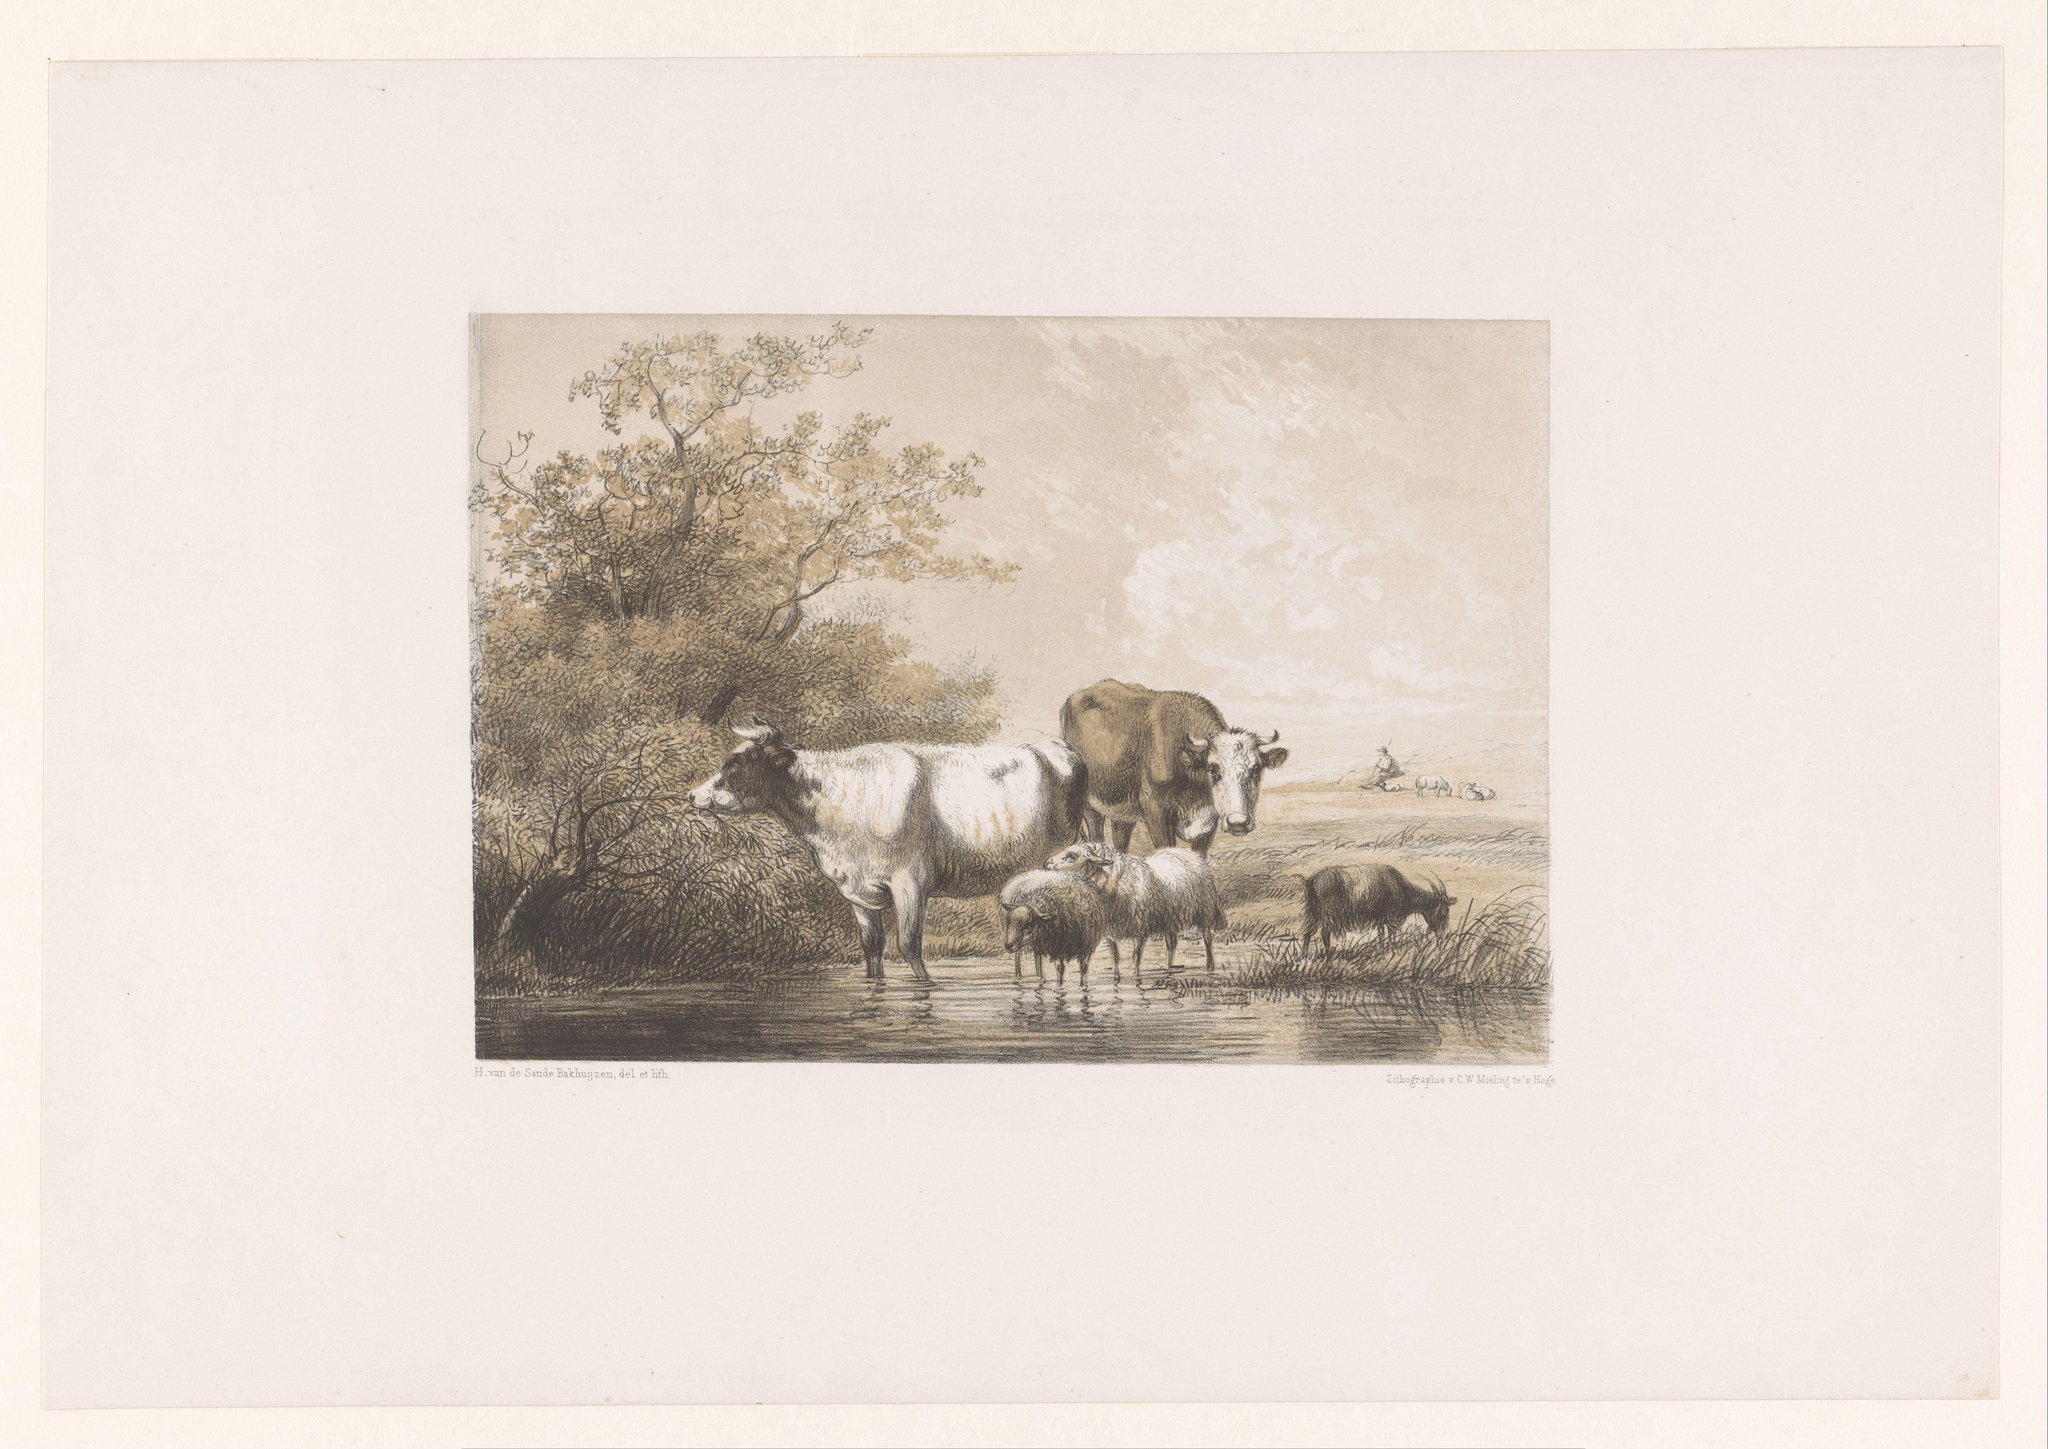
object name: print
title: Koeien en schapen in plas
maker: hendrikus van de sande bakhuyzen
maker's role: draughtsman, painter, print maker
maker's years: 1795-1860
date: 1847-1860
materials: paper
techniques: tone lithography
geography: the hague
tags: cow, sheep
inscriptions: collector's mark: Lugt 2228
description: Twee koeien, twee schapen en een geit staan in een plas water met links bomen. In de achtergrond zit een herder met zijn schapen in het landschap.